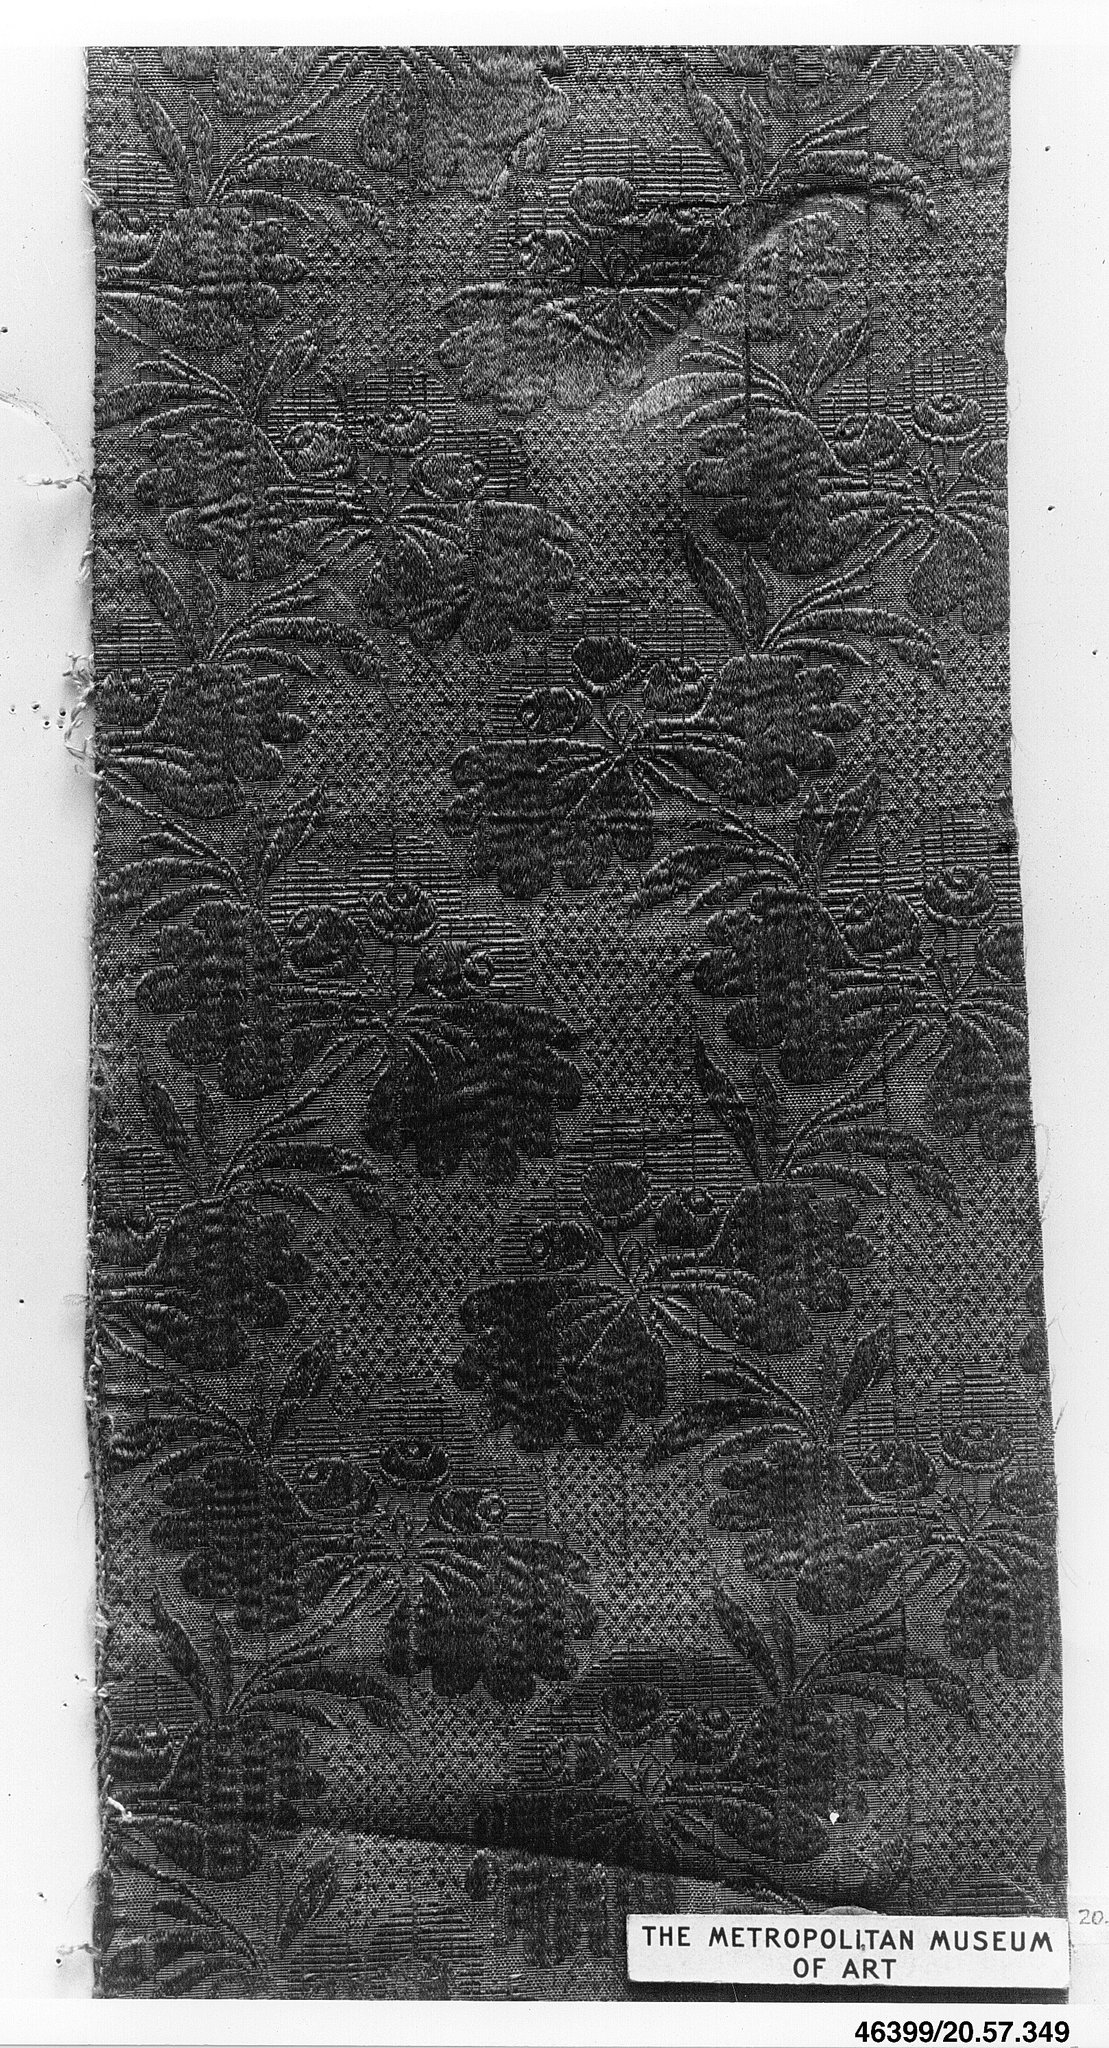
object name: piece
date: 1750-1775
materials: silk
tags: flowers,leaves